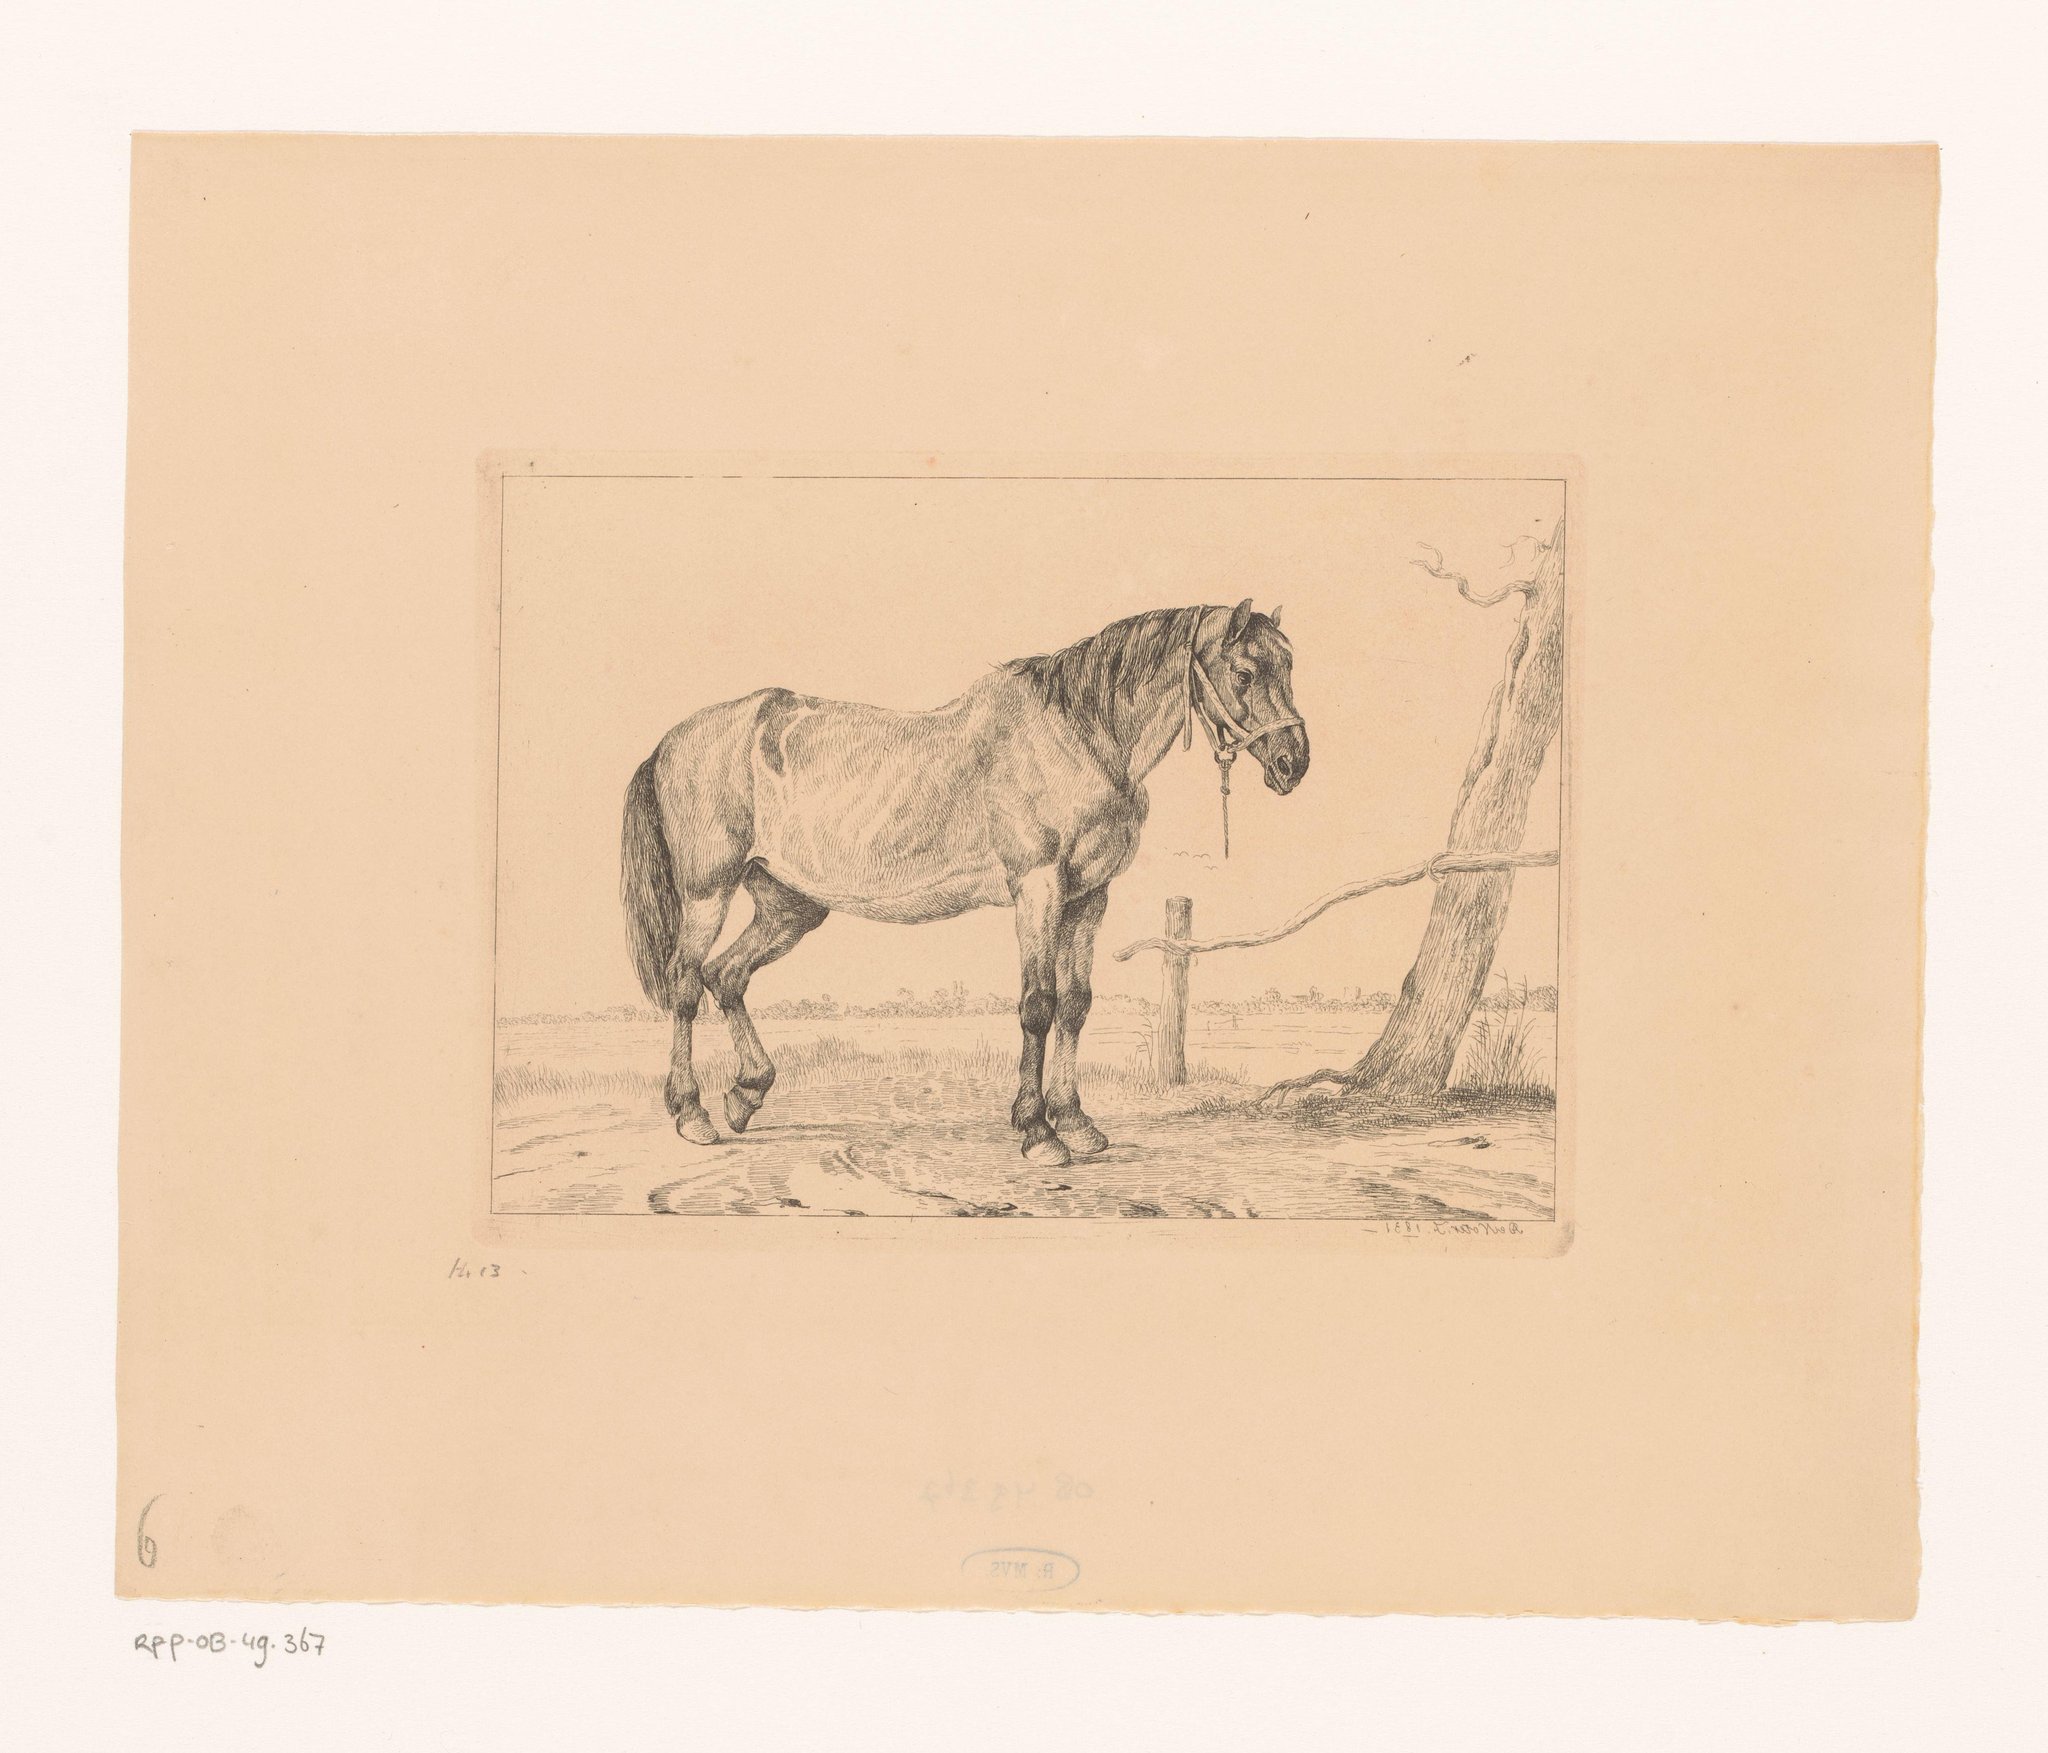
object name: print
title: Paard met halster bij een boom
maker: auguste herman marie de noter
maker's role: print maker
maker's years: 1806-1838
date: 1831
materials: paper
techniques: etching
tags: landscapes, horse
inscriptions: collector's mark: Lugt 2228